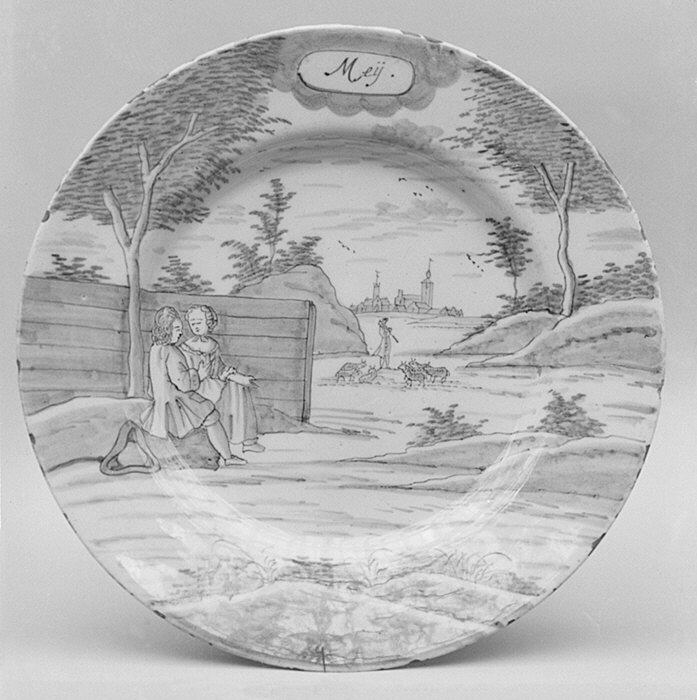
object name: plate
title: Plate (part of a set)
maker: de porceleyne bijl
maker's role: maker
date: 1764-1788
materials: earthenware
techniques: glazing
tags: animals,women,trees